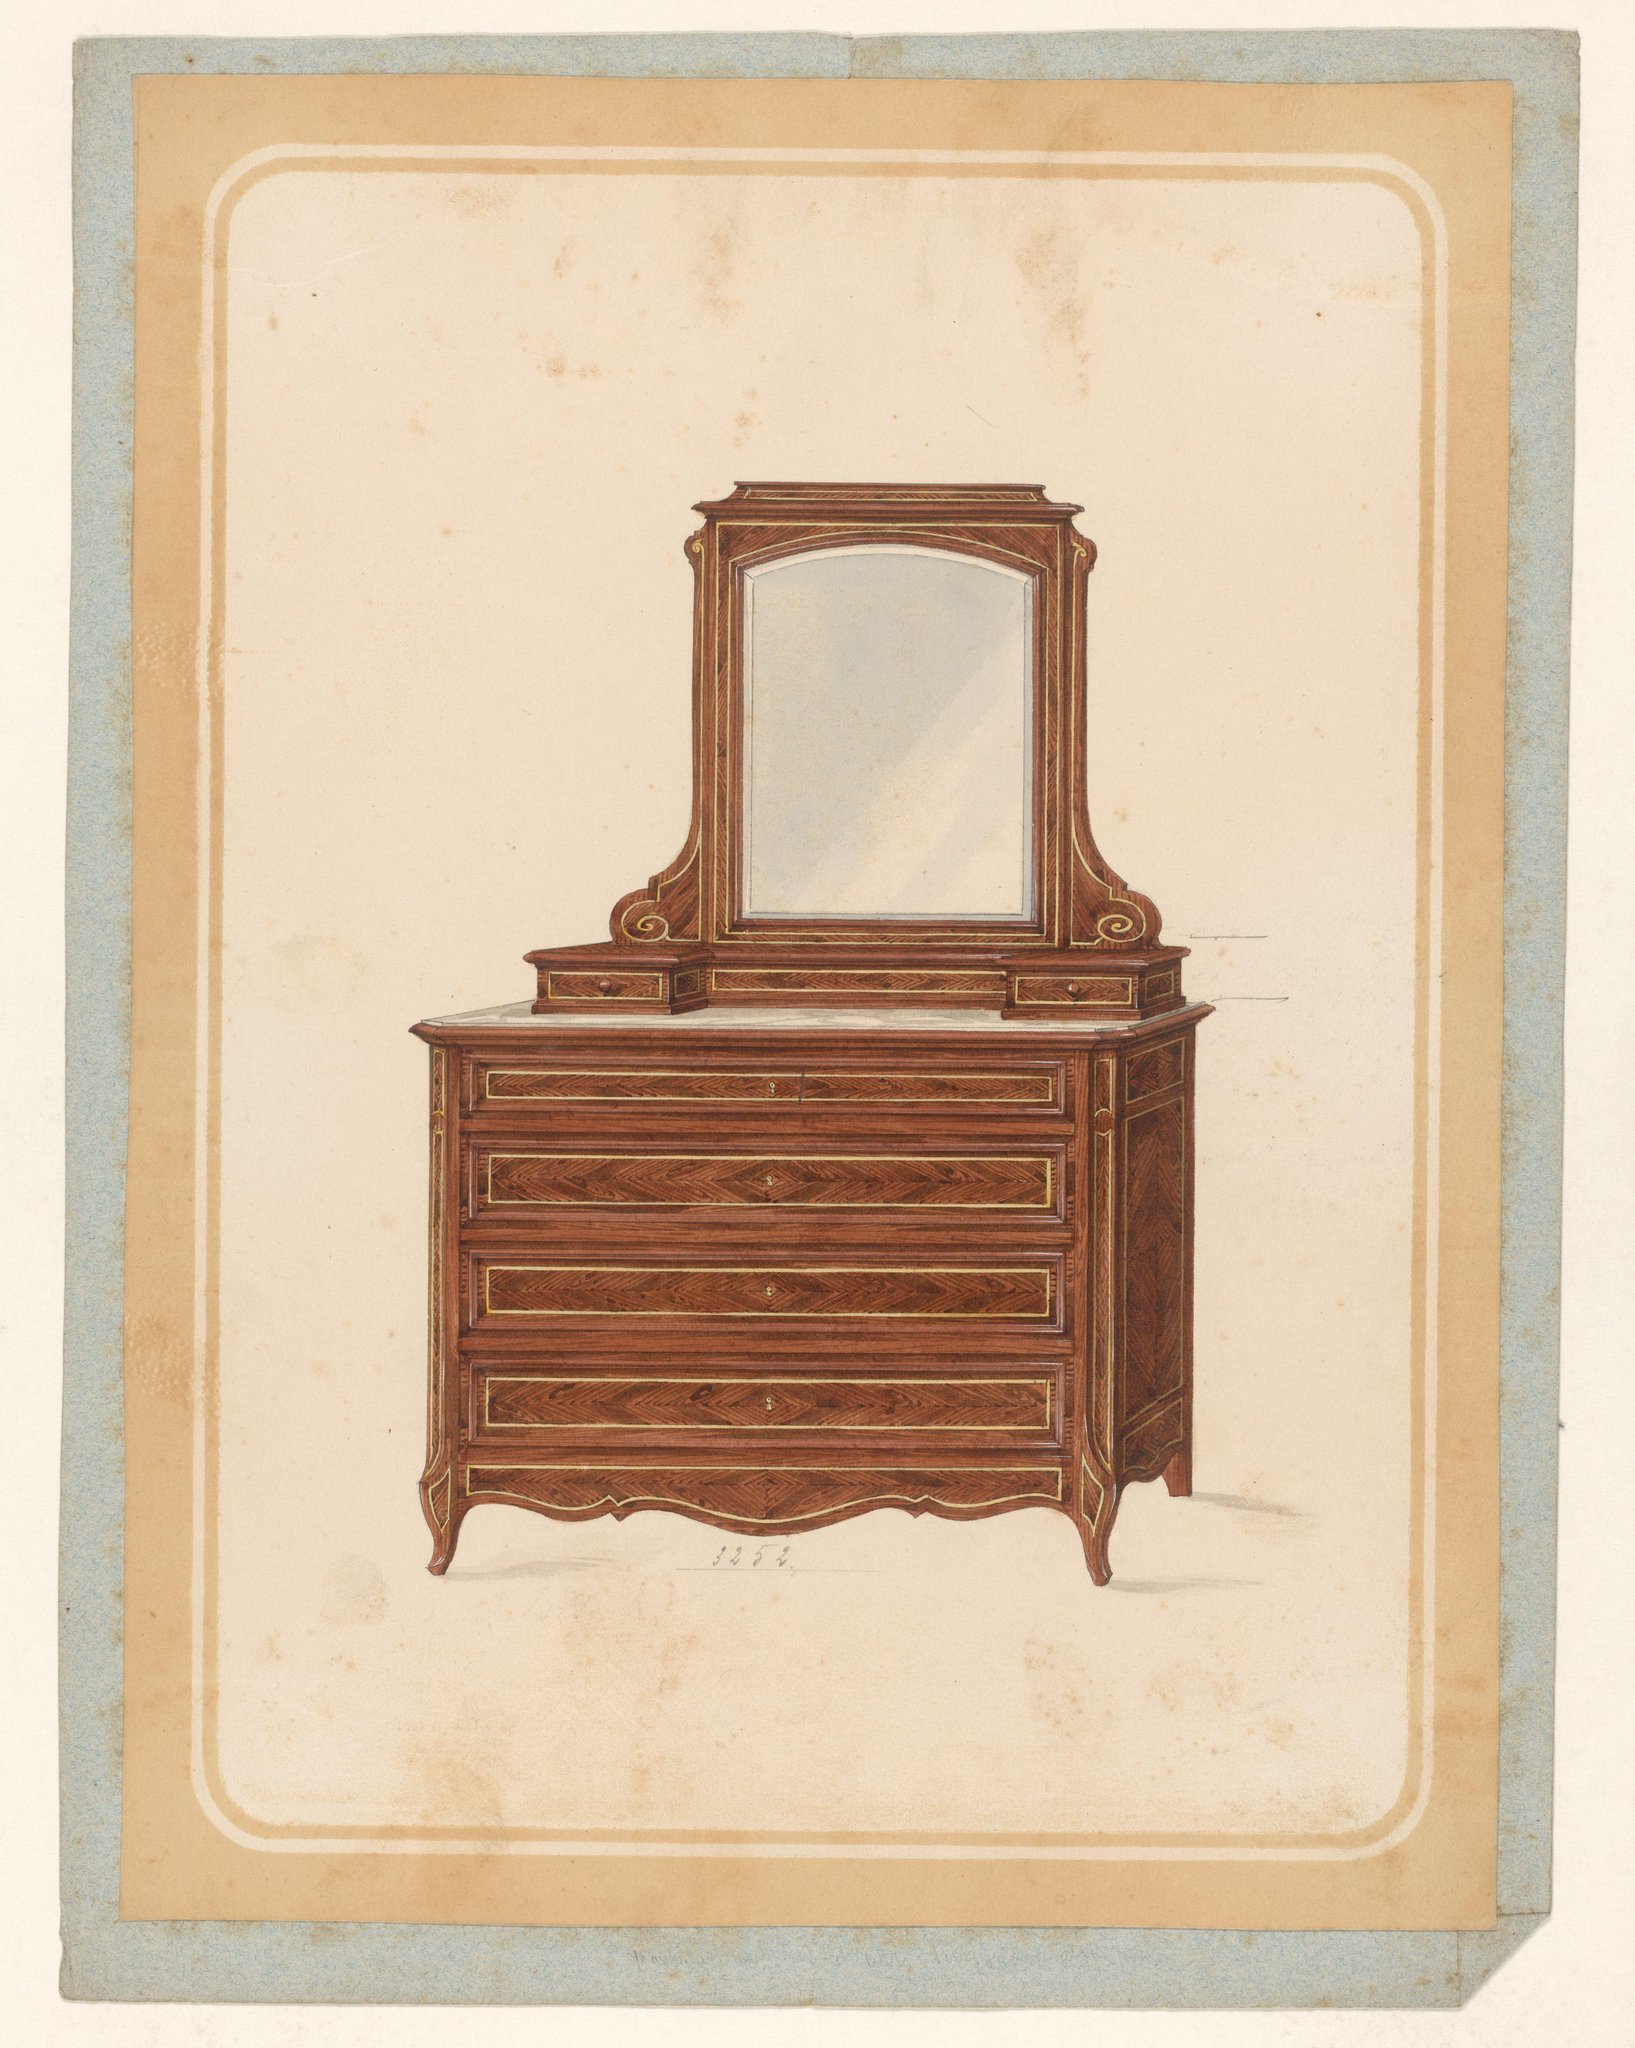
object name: print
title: Dressoir met spiegel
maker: Anonymous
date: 1800-1900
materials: paper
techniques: hand coloring, lithograph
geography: france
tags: furniture for storage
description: Een dressoir met spiegel en lades. In potlood genummerd 3252.